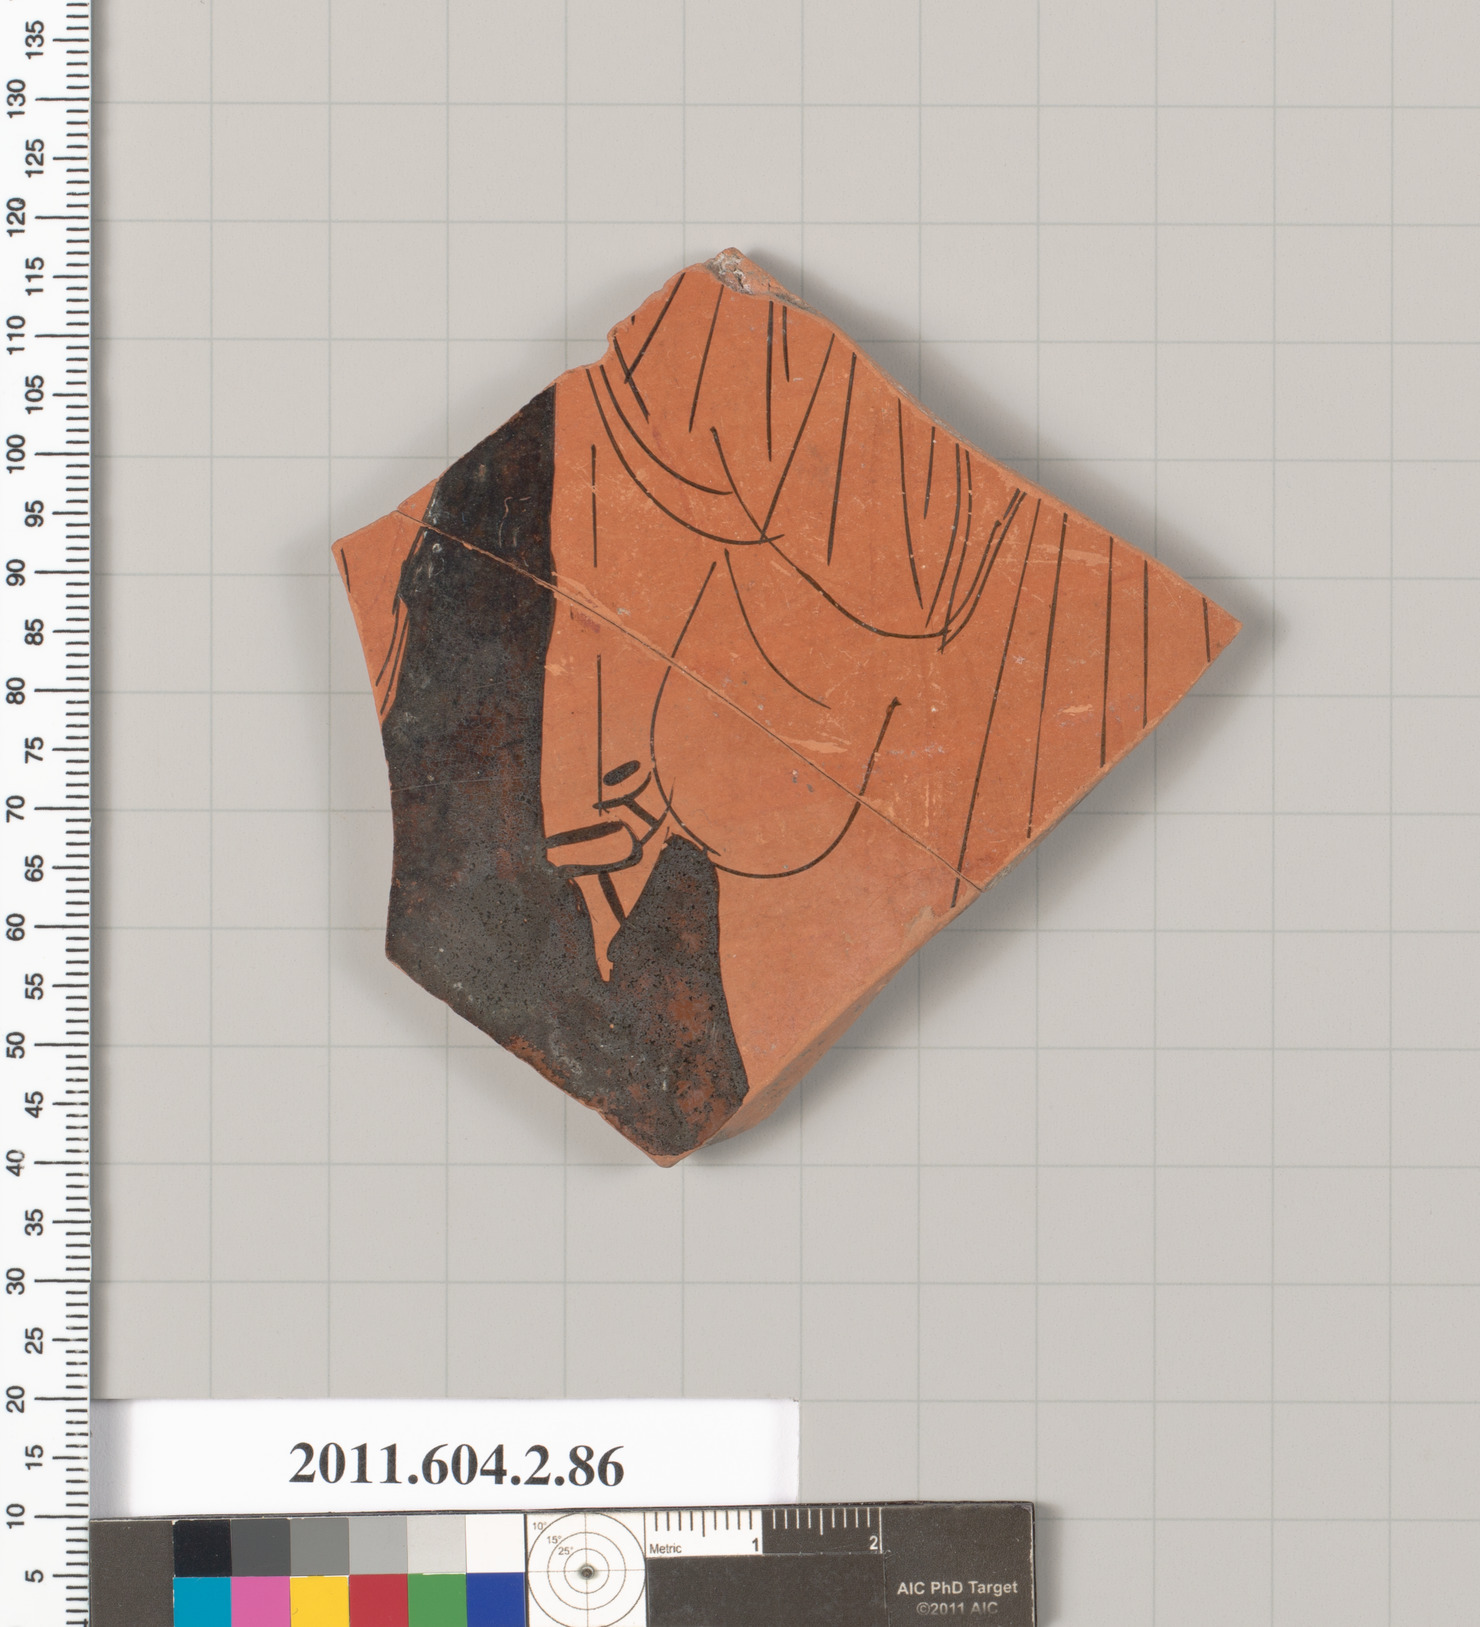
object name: pelike fragment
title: Terracotta fragment of a pelike (jar)?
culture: greek, attic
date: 475-451 BCE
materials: terracotta